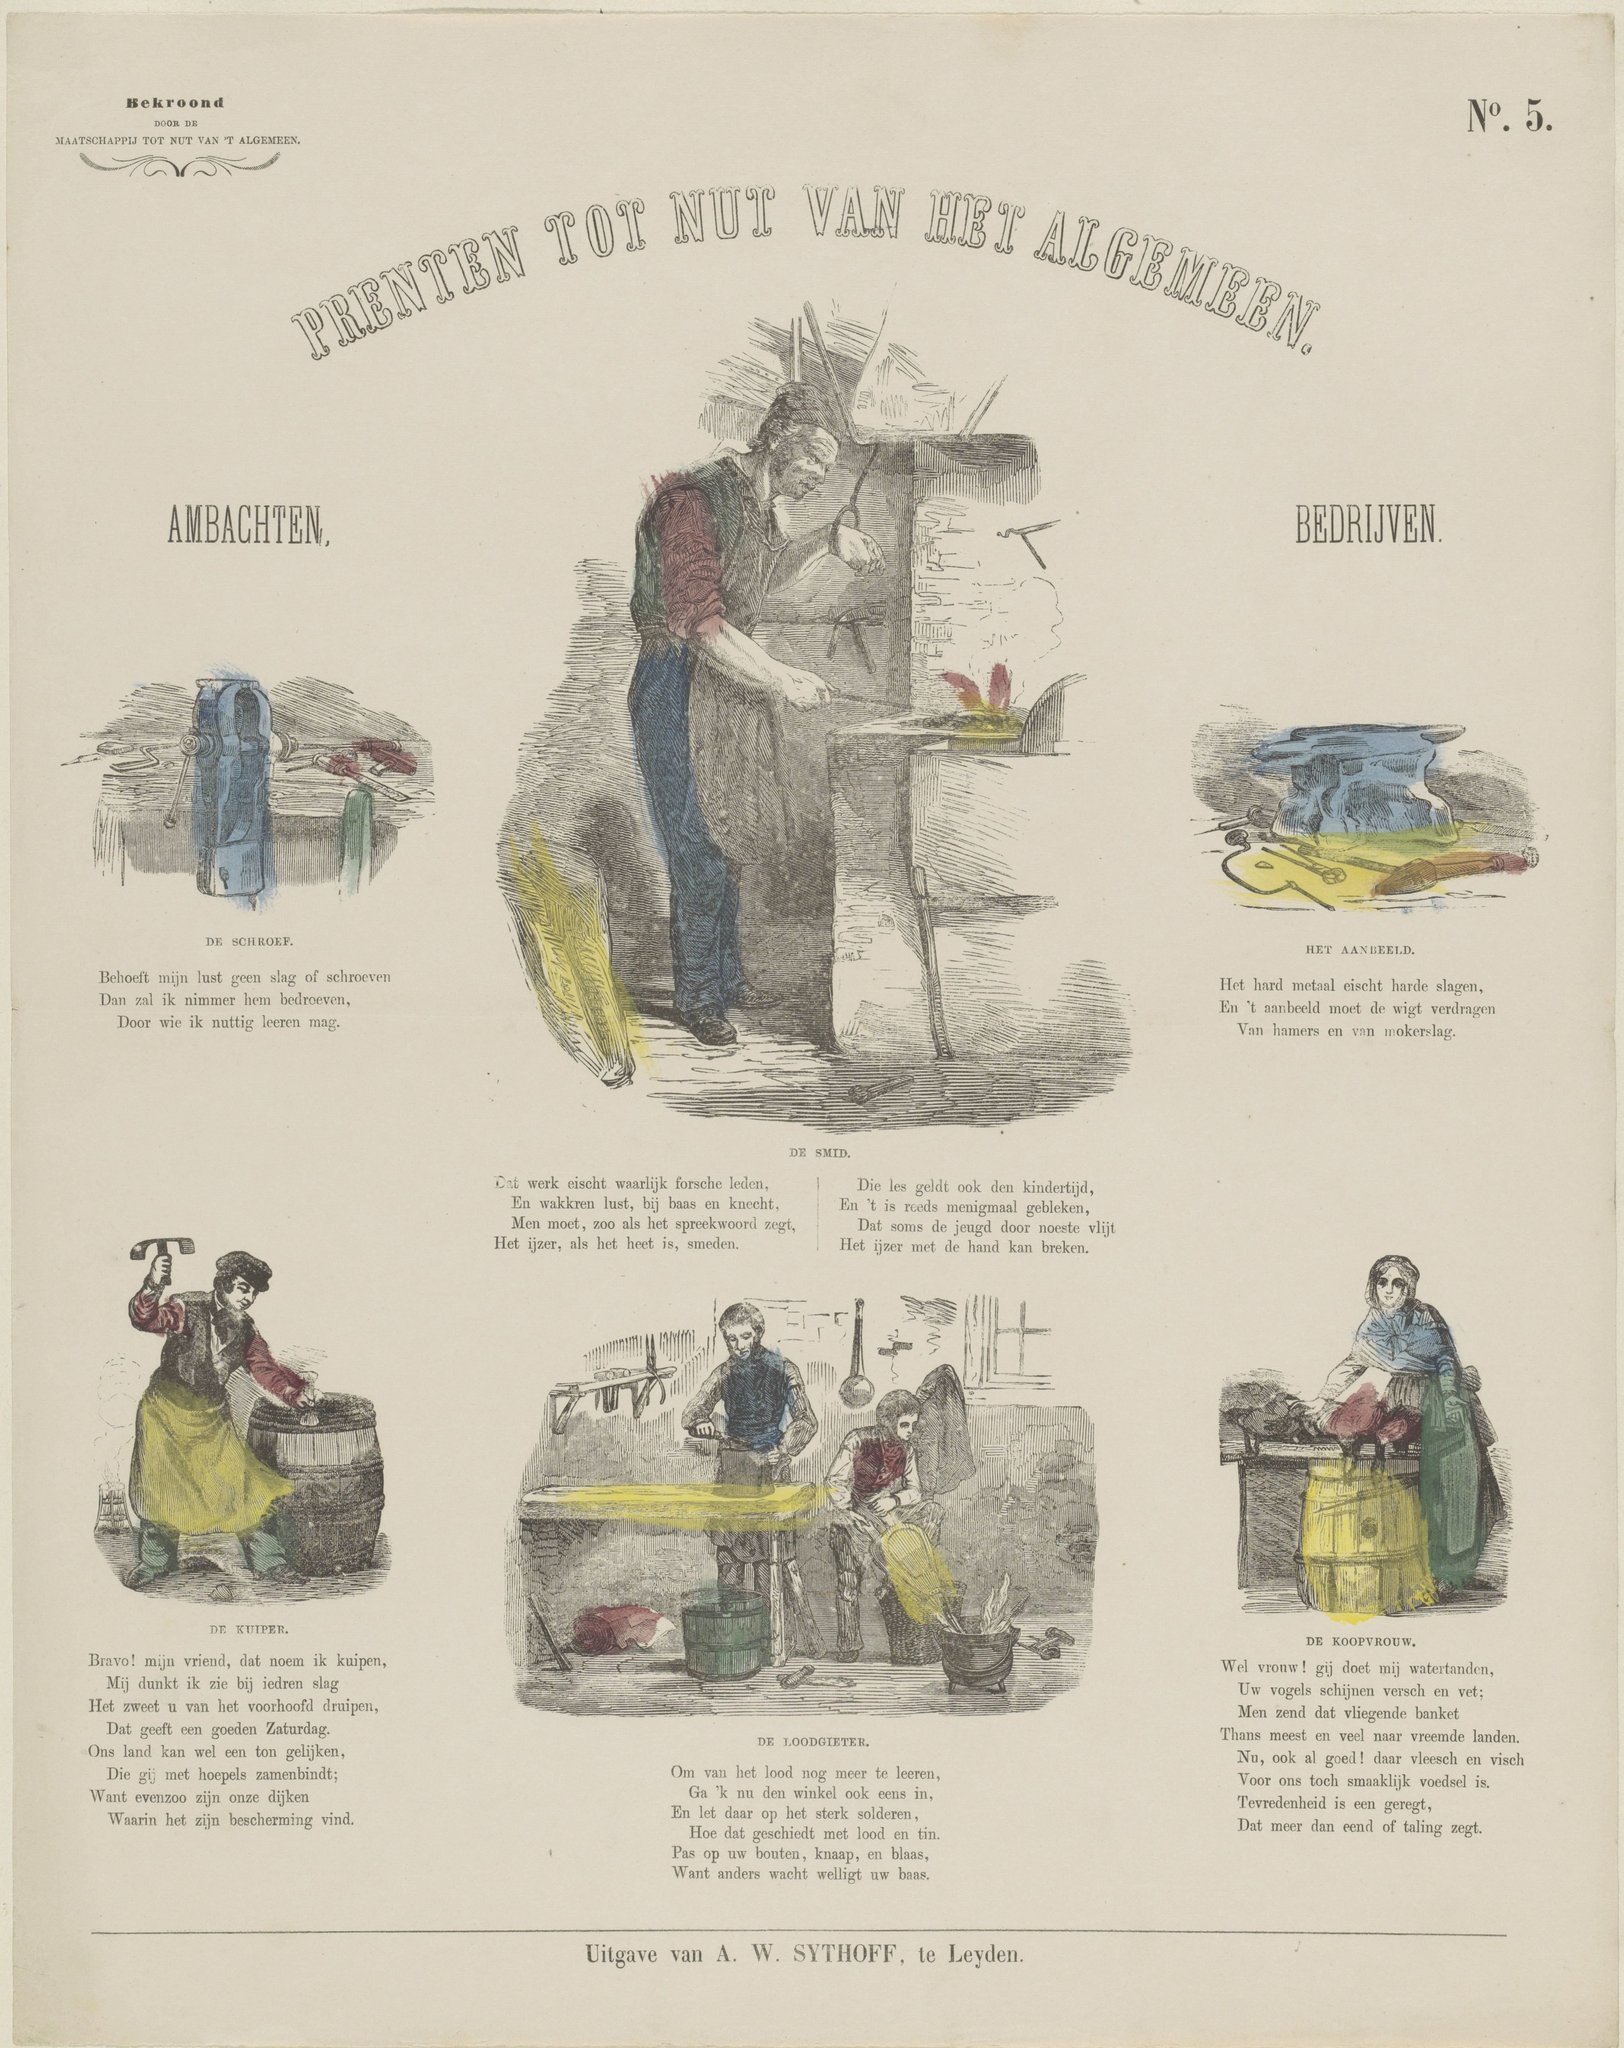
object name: print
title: Prenten tot nut van het algemeen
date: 1861-1929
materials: paper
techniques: colour, letterpress printing, engraving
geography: europe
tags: tools, aids, implements ~ crafts and industries, plumber, street-trader, smith, blacksmith, tools, aids, implements ~ crafts and industries: anvil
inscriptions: collector's mark: Lugt 2760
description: Blad met 6 voorstellingen van een schroefbank, een smid, een aambeeld, een kuiper een loodgieter en een koopvrouw. Onder elke voorstelling een titel en een vers. Genummerd rechtsboven: No. 5. Linksboven: Bekroond door de Maatschappij tot Nut van 't Algemeen.